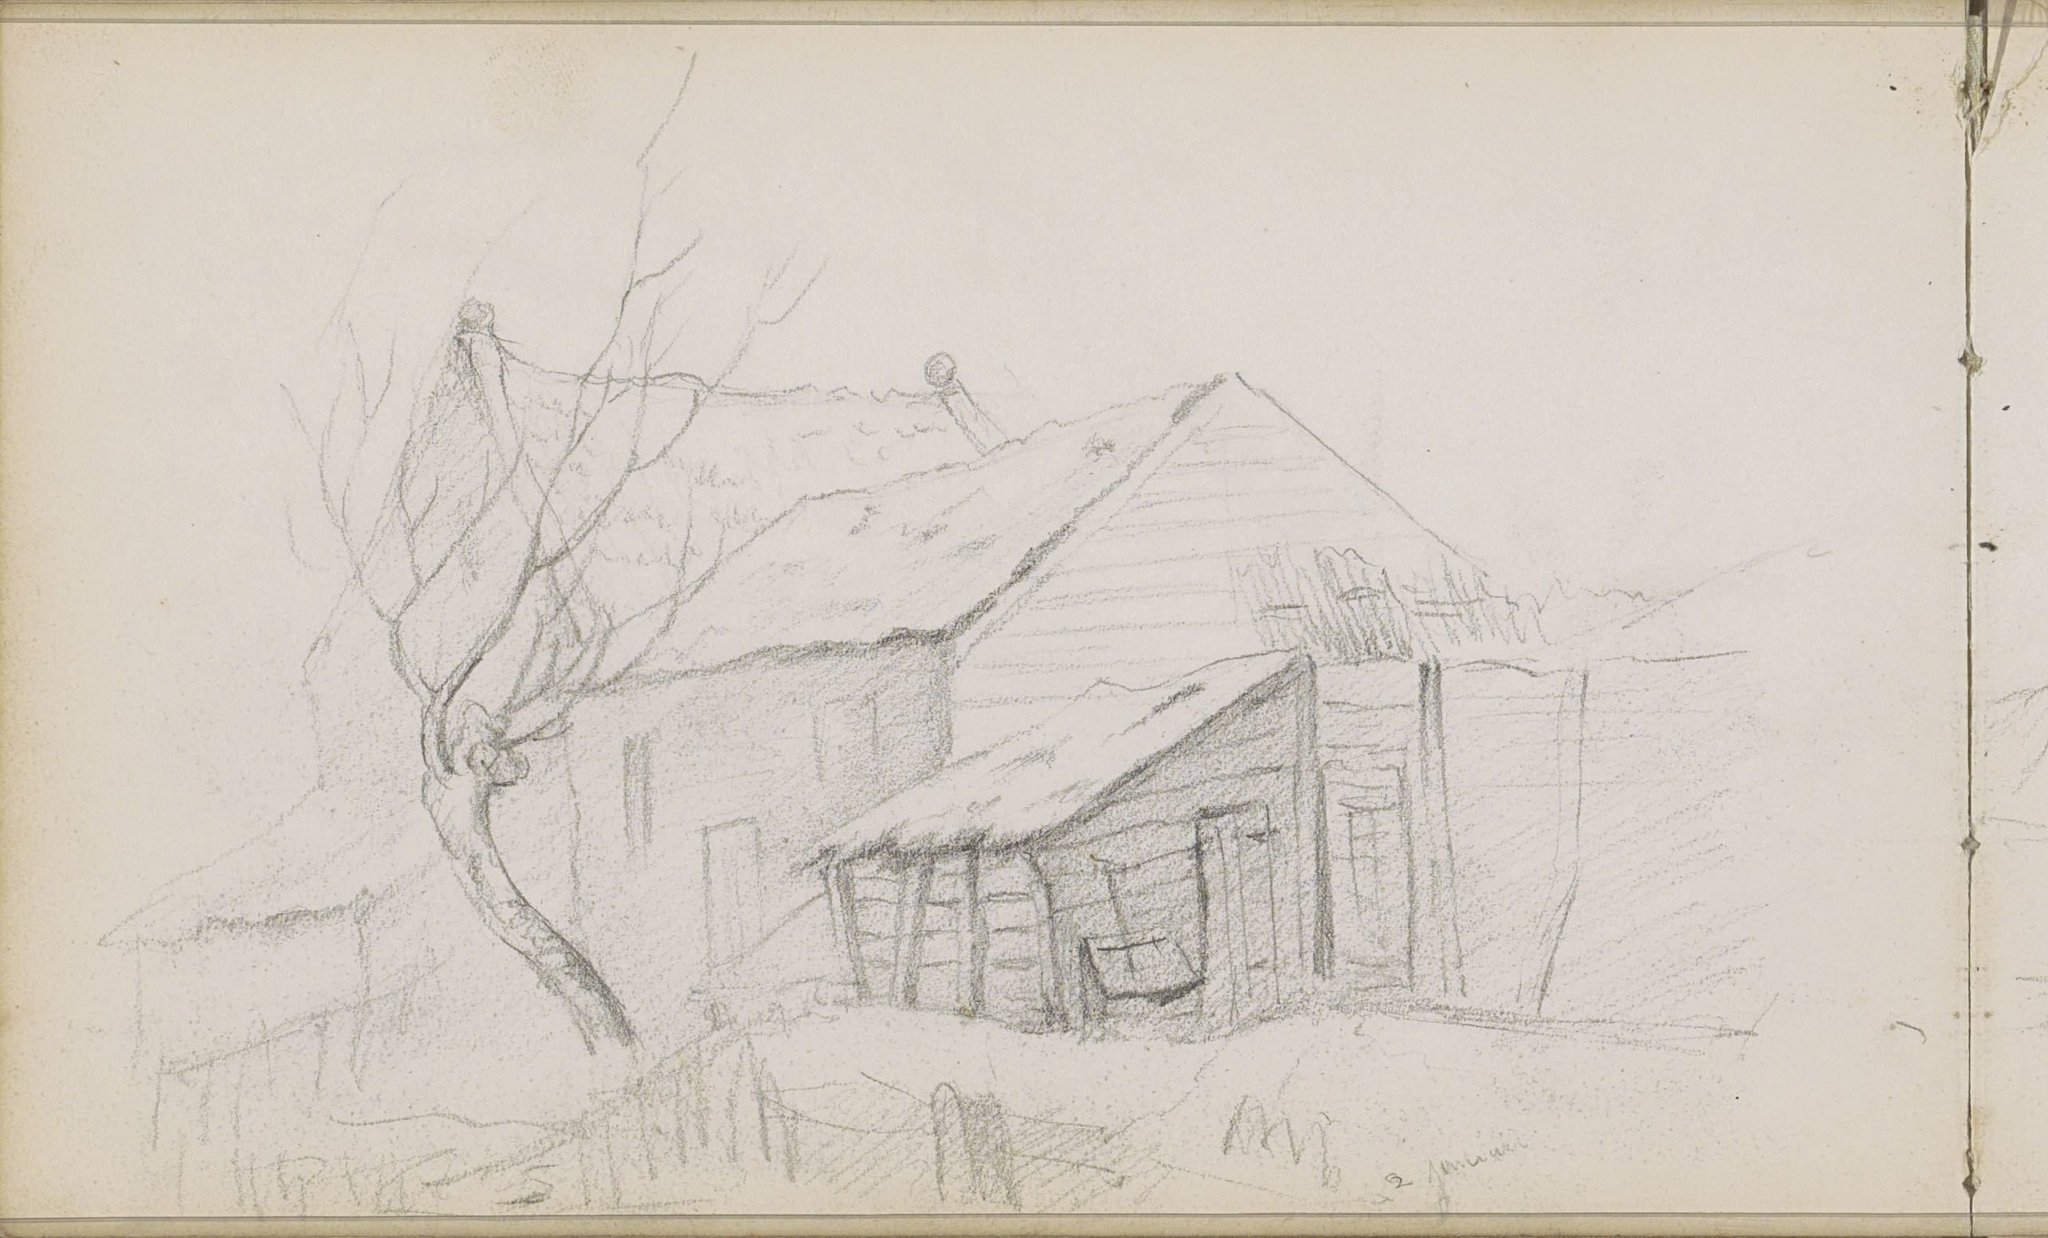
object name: sketchbook leaf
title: Arbeiderswoningen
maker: willem cornelis rip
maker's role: draughtsman, painter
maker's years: 1856-1922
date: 1874-1875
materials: paper, pencil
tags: cottage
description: Blad 5 verso uit een schetsboek met 46 bladen.